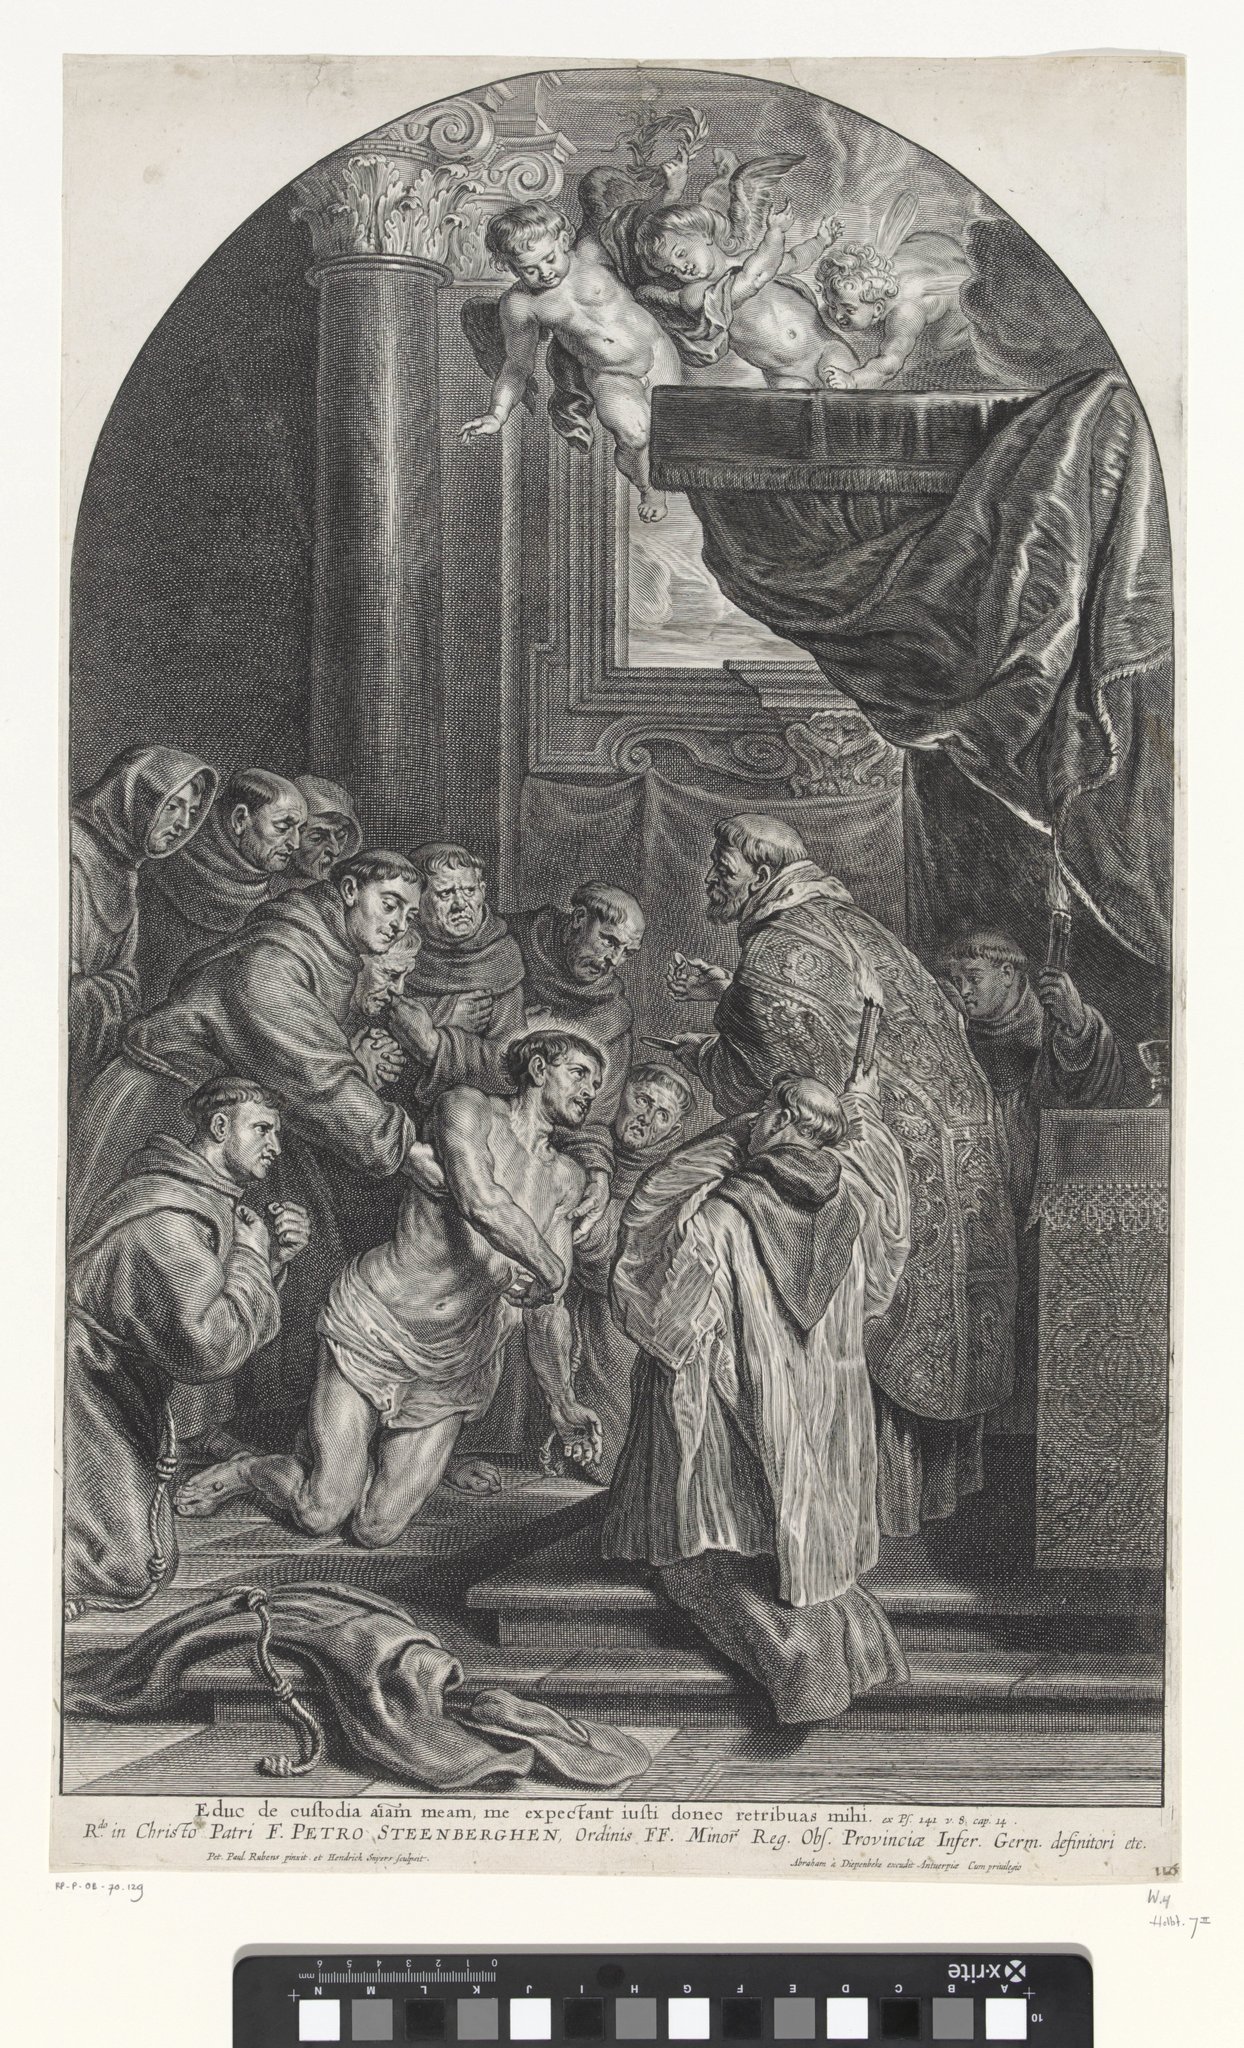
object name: print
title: Laatste communie van H. Franciscus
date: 1621-1643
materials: paper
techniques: engraving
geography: antwerp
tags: extreme unction ~ the last of the seven sacraments, founder of the order of friars minor (franciscans), francis(cus) of assisi; possible attributes: book, crucifix, lily, skull, stigmata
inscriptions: collector's mark: Lugt 240